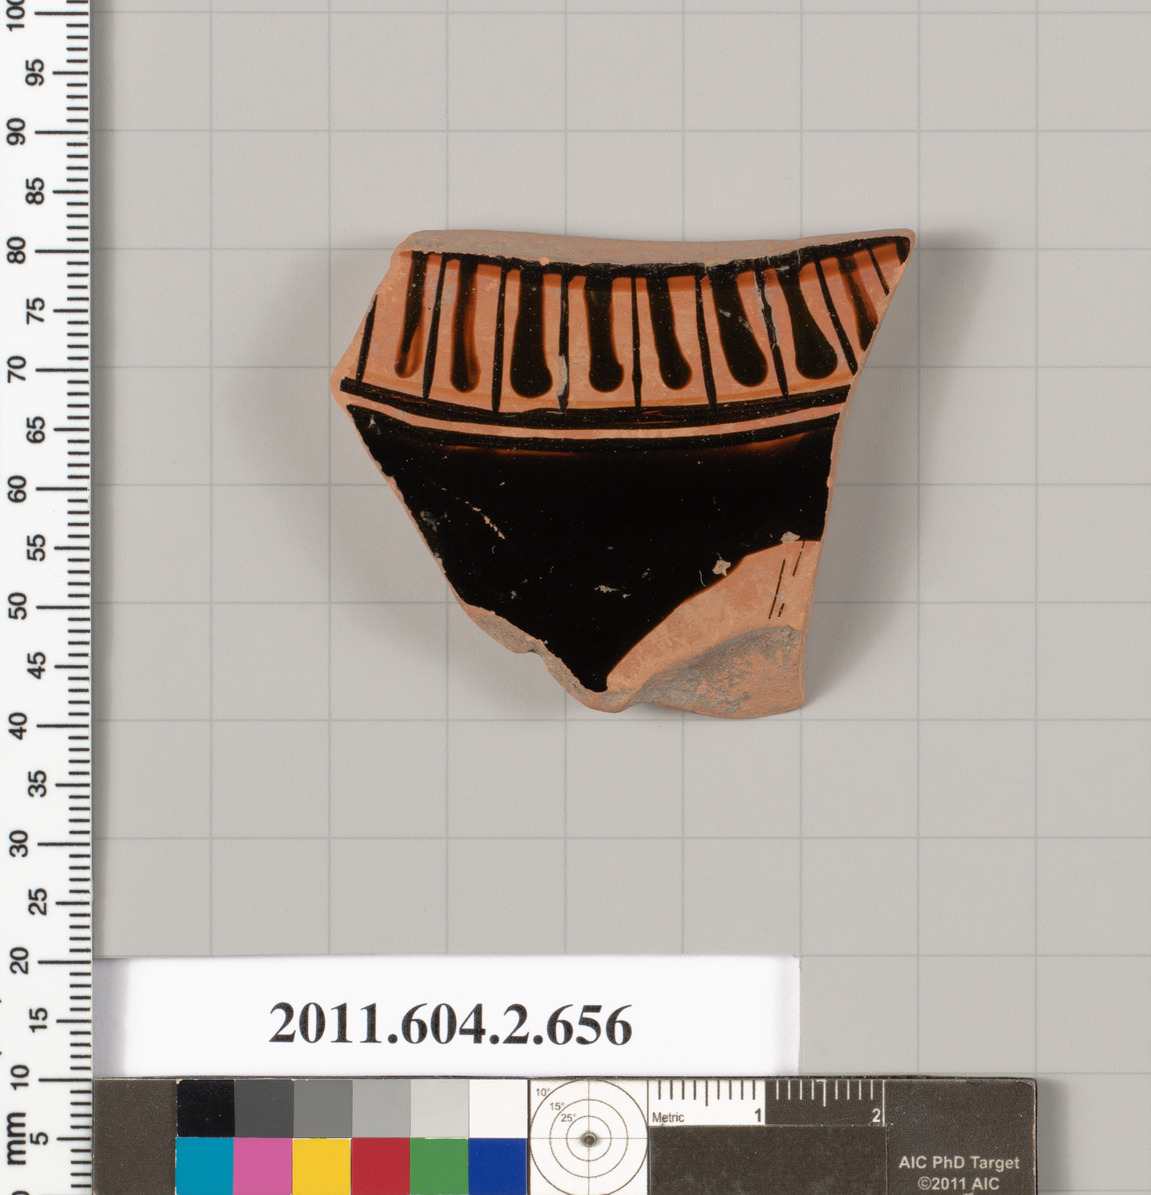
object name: column krater fragment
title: Terracotta fragment of a column-krater (bowl for mixing wine and water)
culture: greek, attic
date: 460-450 BCE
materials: terracotta